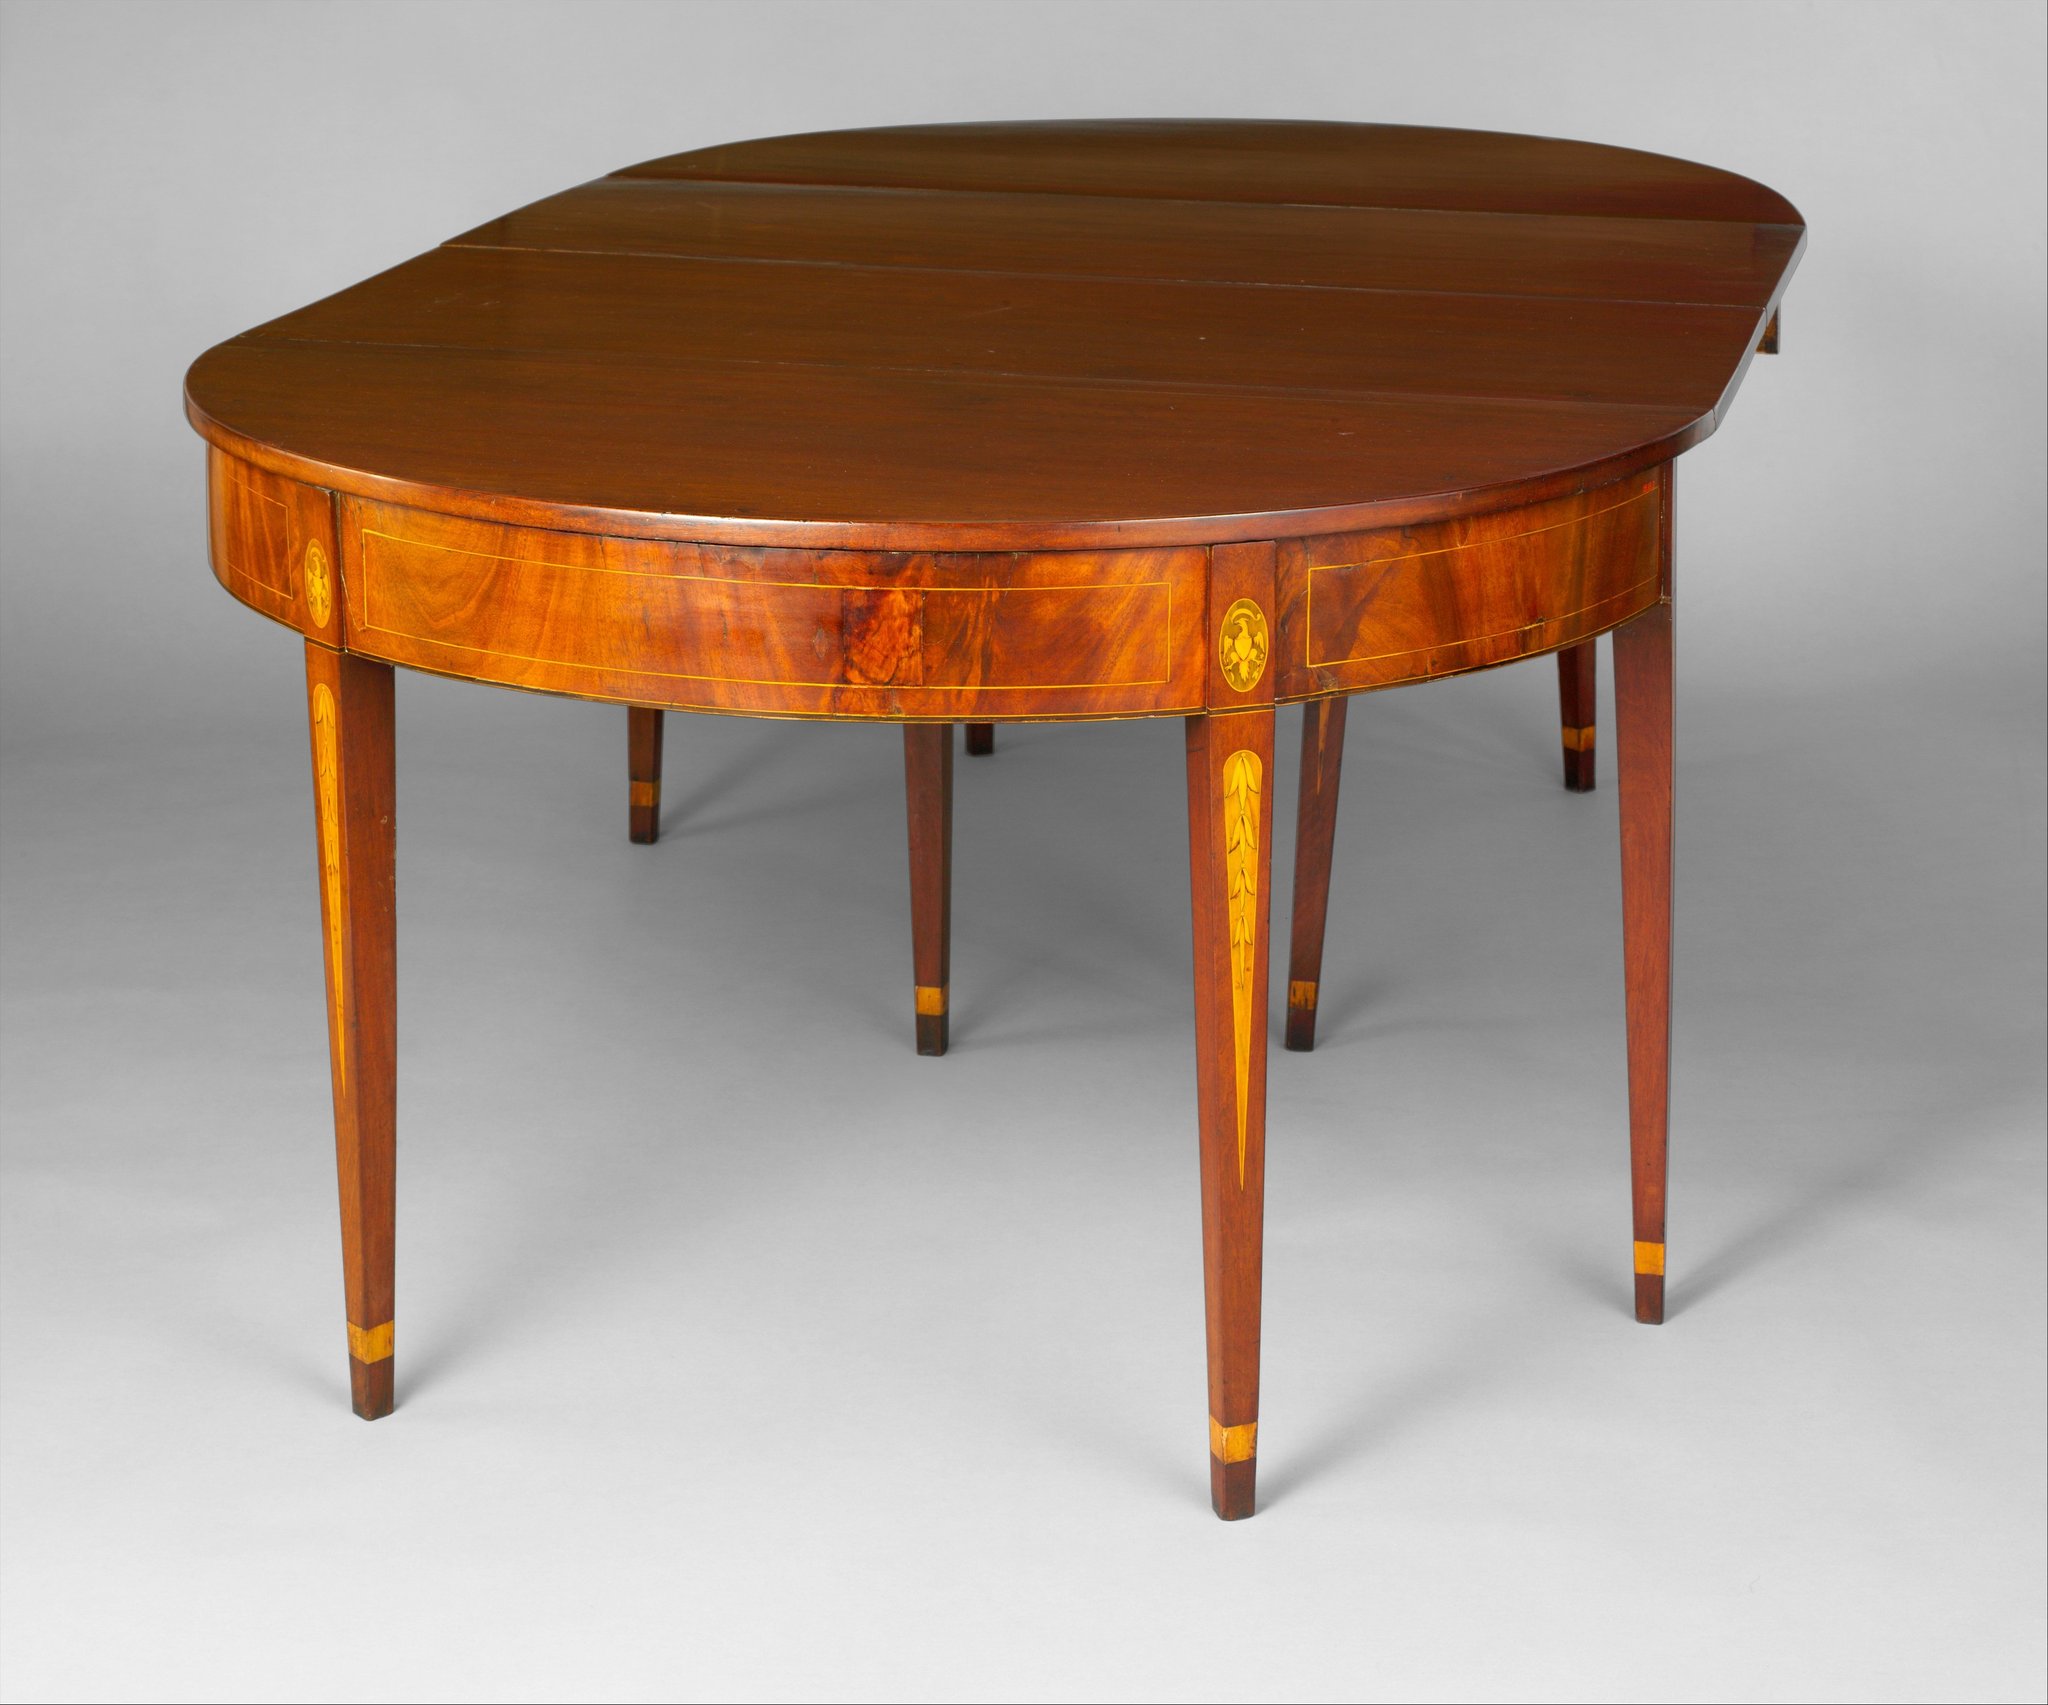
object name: drop leaf dining table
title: Drop-leaf Dining Table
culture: american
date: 1795-1810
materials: wood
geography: united states